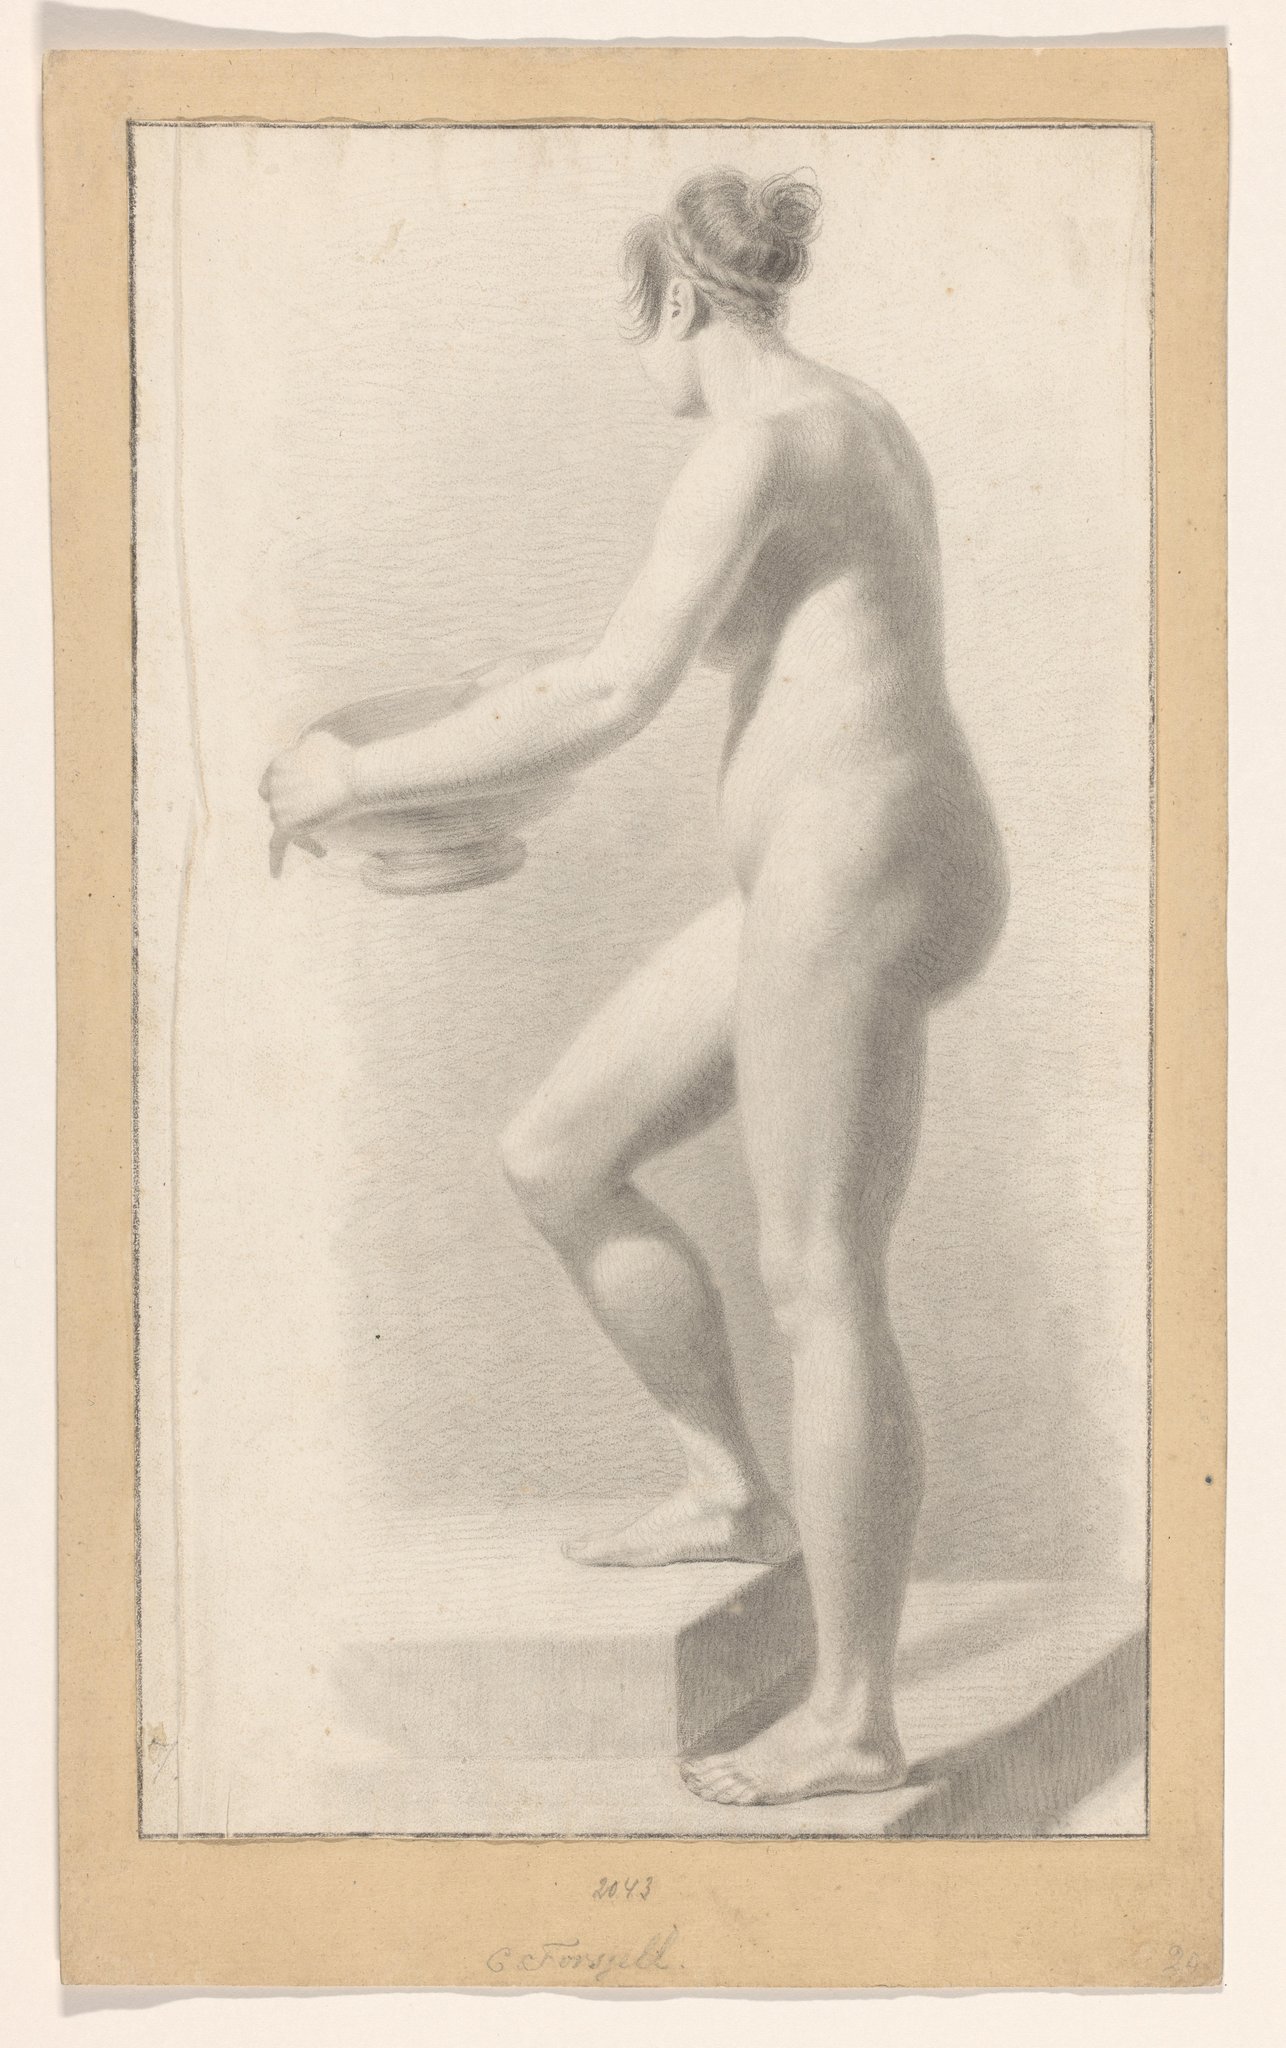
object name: drawing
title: Studie van een staand vrouwelijk naakt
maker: christian forssell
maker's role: print maker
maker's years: 1777-1852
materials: chalk, paper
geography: amsterdam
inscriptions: inscription: ‘21 Maart 1806 Welmeer / 28 dito - Welmeer / 4 April 1806 - Welmeer / 10 April 1806 [naam onleesbaar]’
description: Vrouwelijk naakt stapt met rechtervoet op een verhoging en houdt met beide handen een brede pot vast.